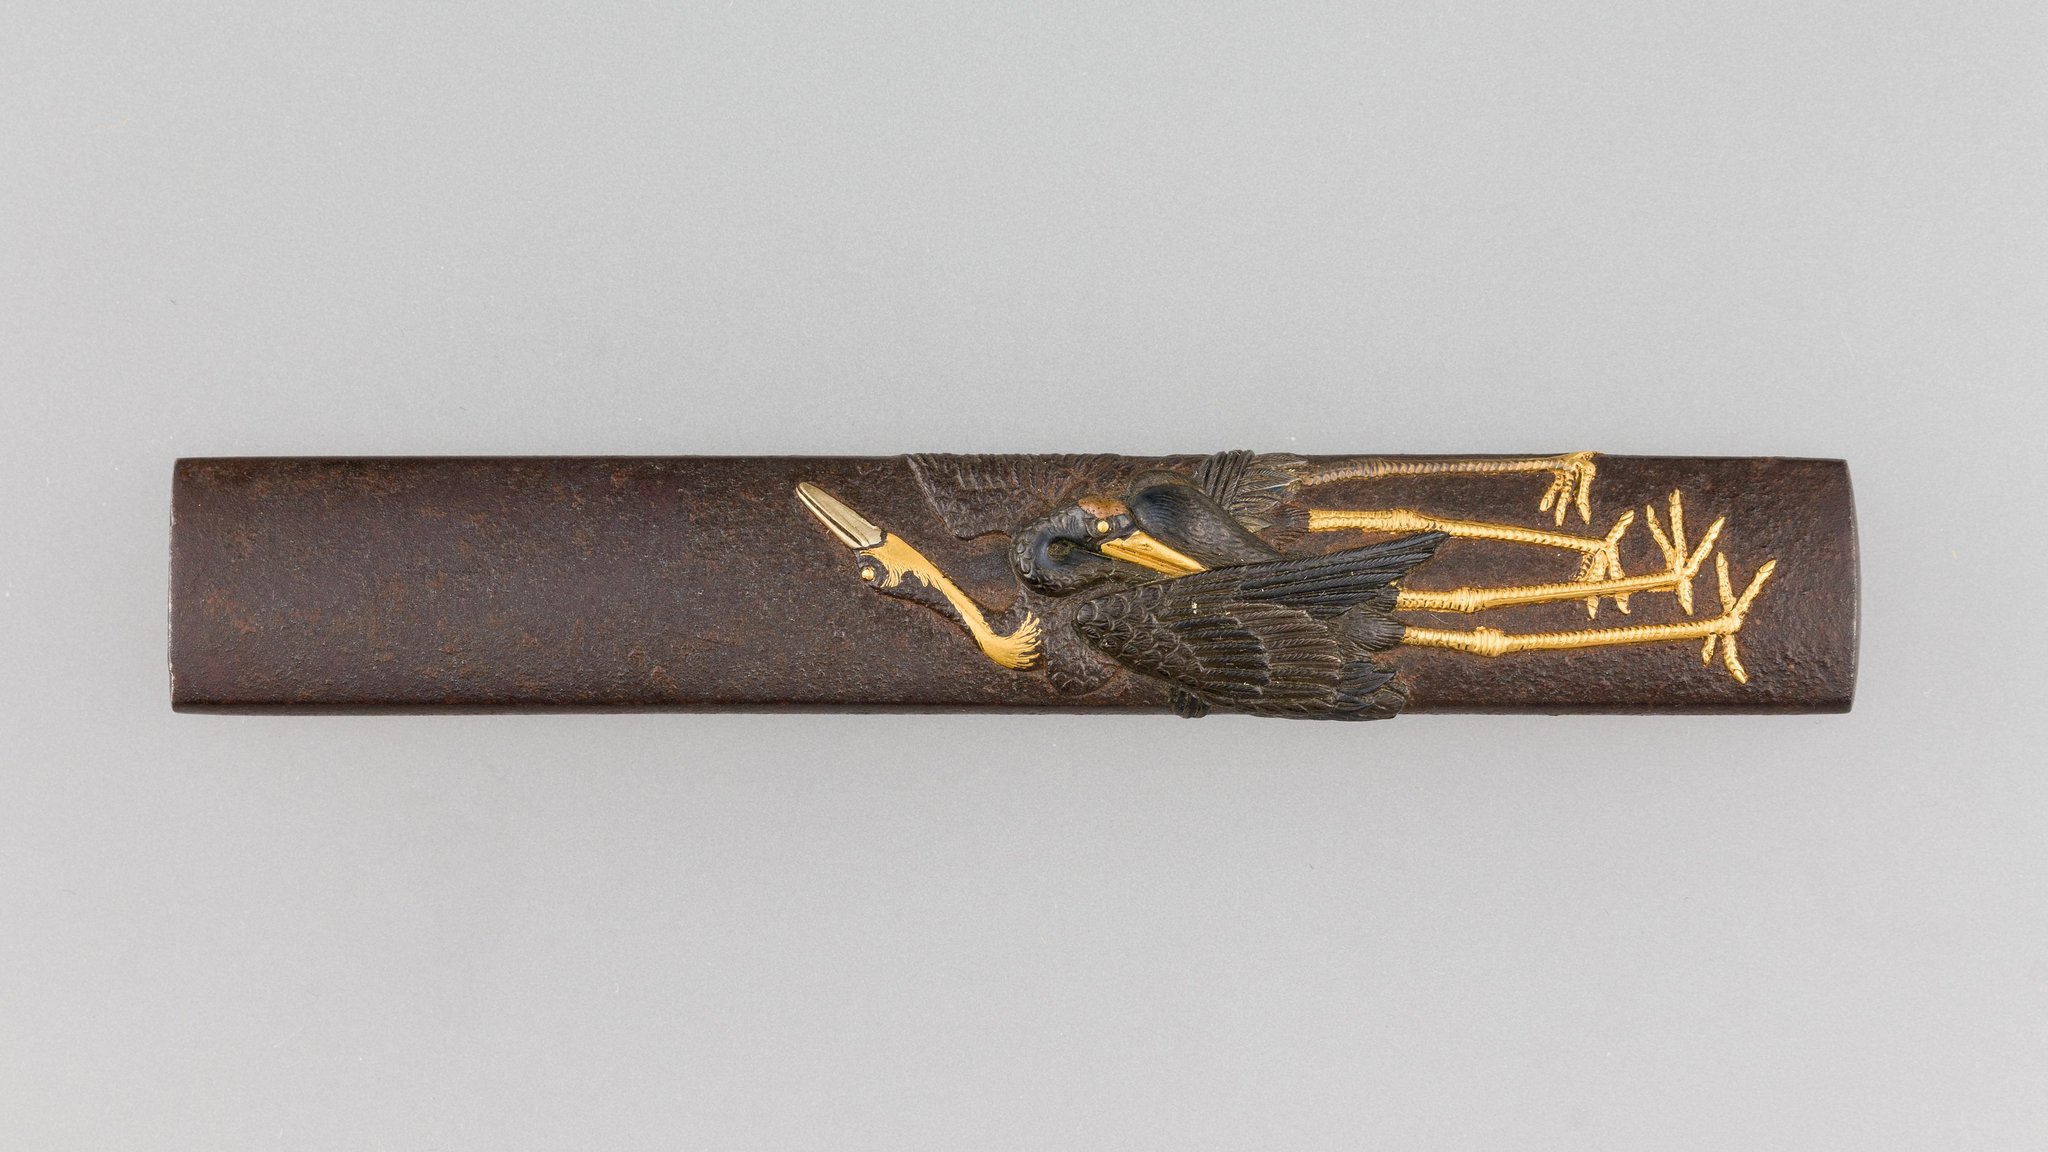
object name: knife handle kozuka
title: Knife Handle (Kozuka)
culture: japanese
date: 1701-1800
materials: gold alloy, silver alloy, iron, silver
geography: japan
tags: cranes